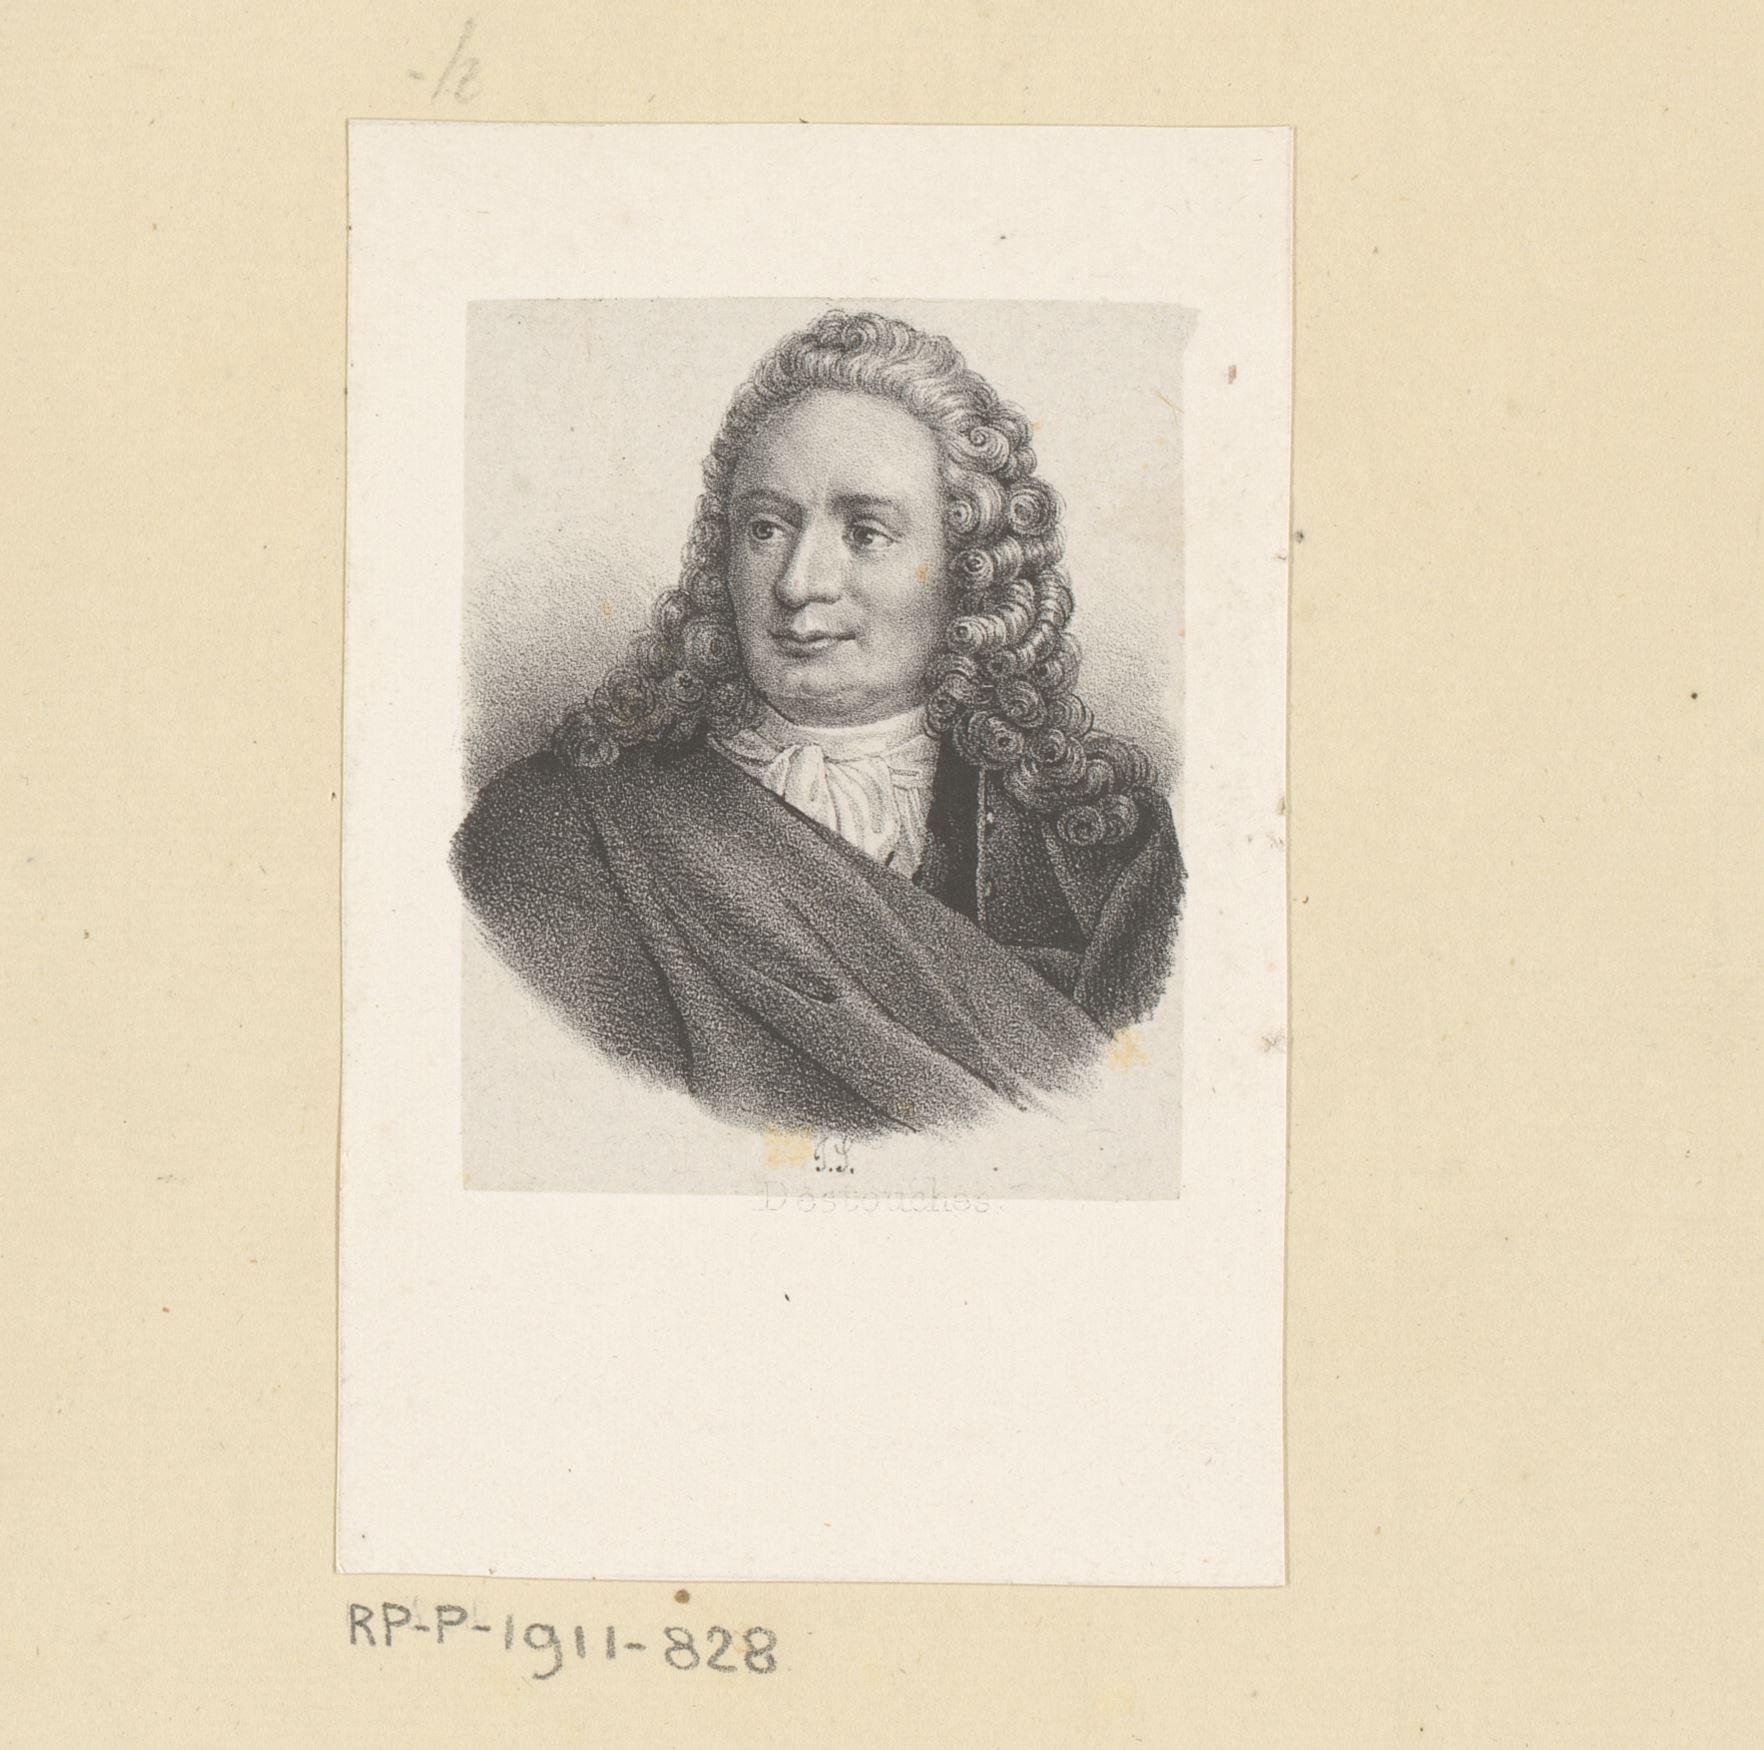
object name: print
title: Portret van Philippe Néricault Destouches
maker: joseph schubert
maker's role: print maker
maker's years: 1816-1885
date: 1841-1885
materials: paper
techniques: lithograph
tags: philippe néricault destouches, historical persons, portrait of a writer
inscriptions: collector's mark: Lugt 2228